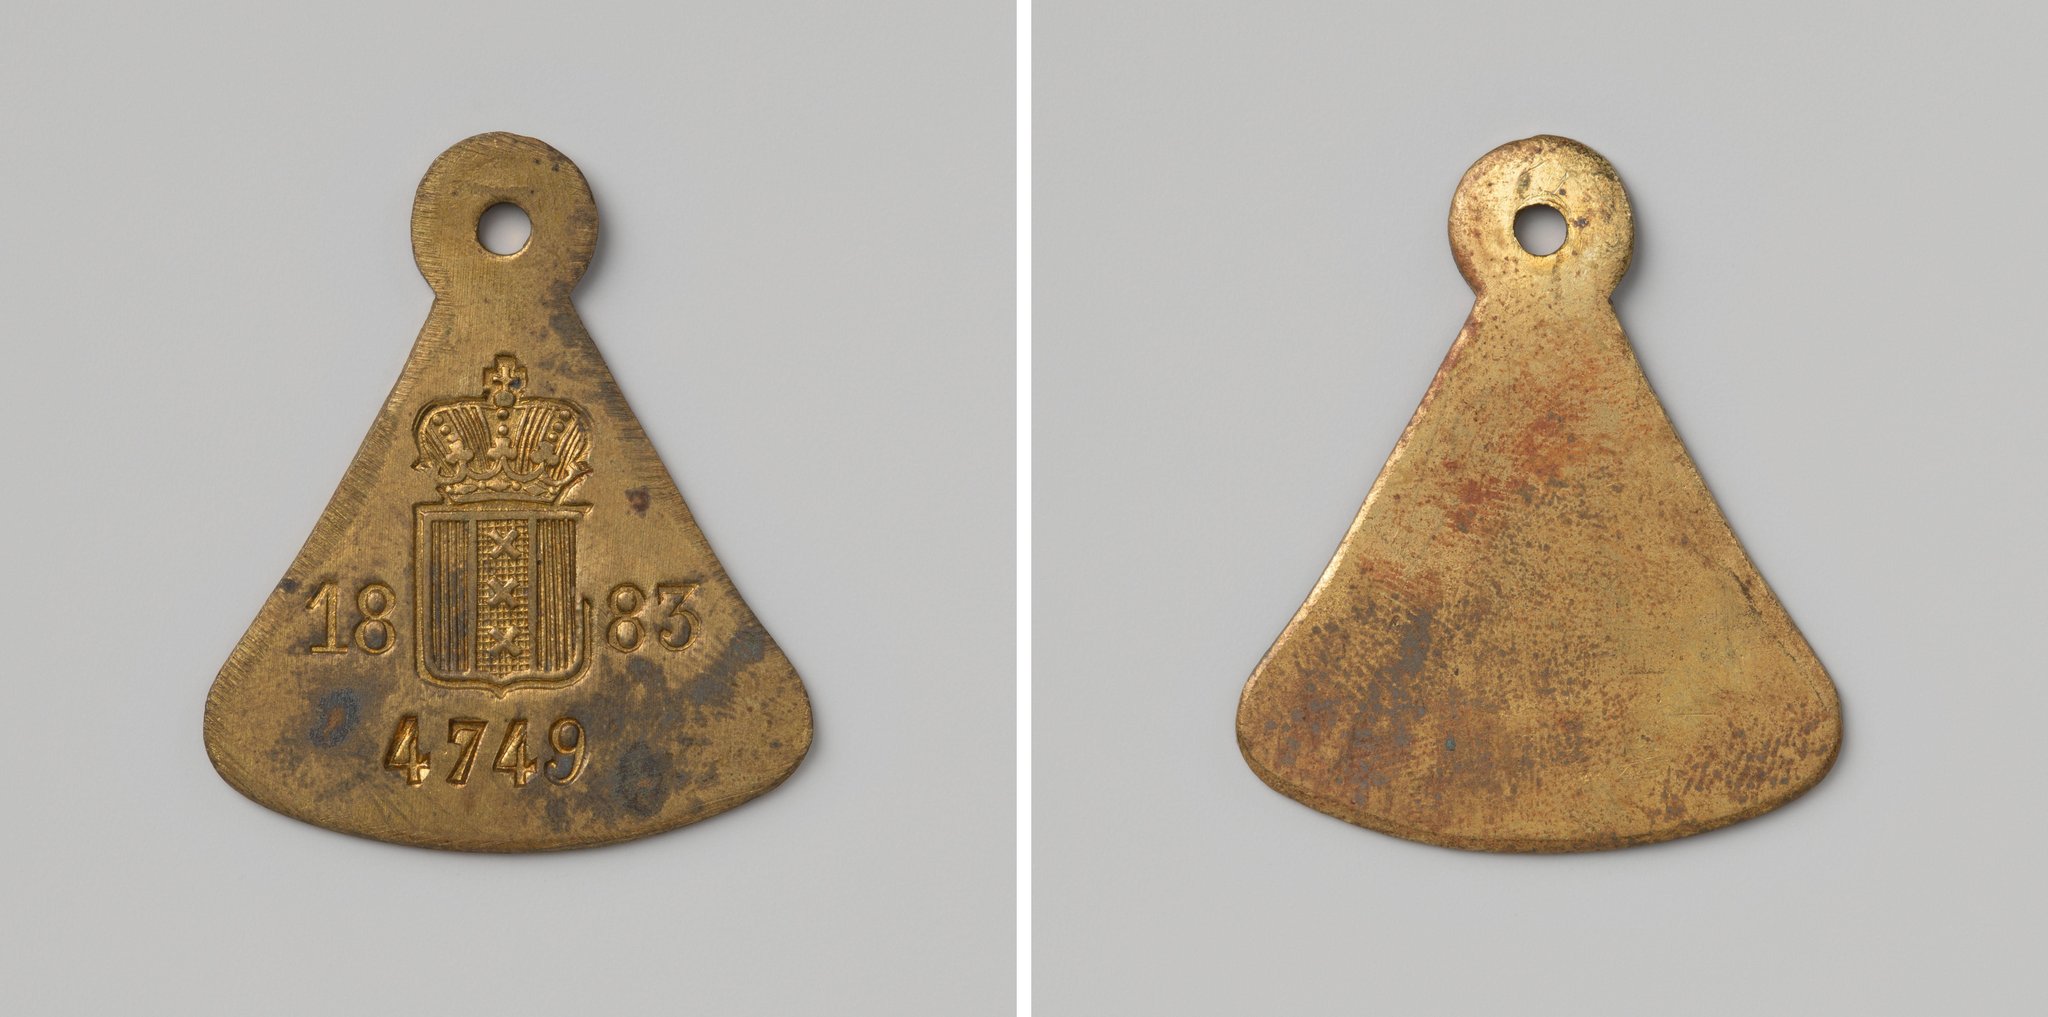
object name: tax token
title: Stad Amsterdam, loodje met no. 4749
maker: Anonymous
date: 1883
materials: brass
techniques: striking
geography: amsterdam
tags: amsterdam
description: eenzijdig, driehoekig loodje aan draagoog met afgeronde hoeken en bolle onderzijde. Voorzijde: gekroond wapenschild tussen jaartal boven cijfer 4749. Keerzijde: blanco